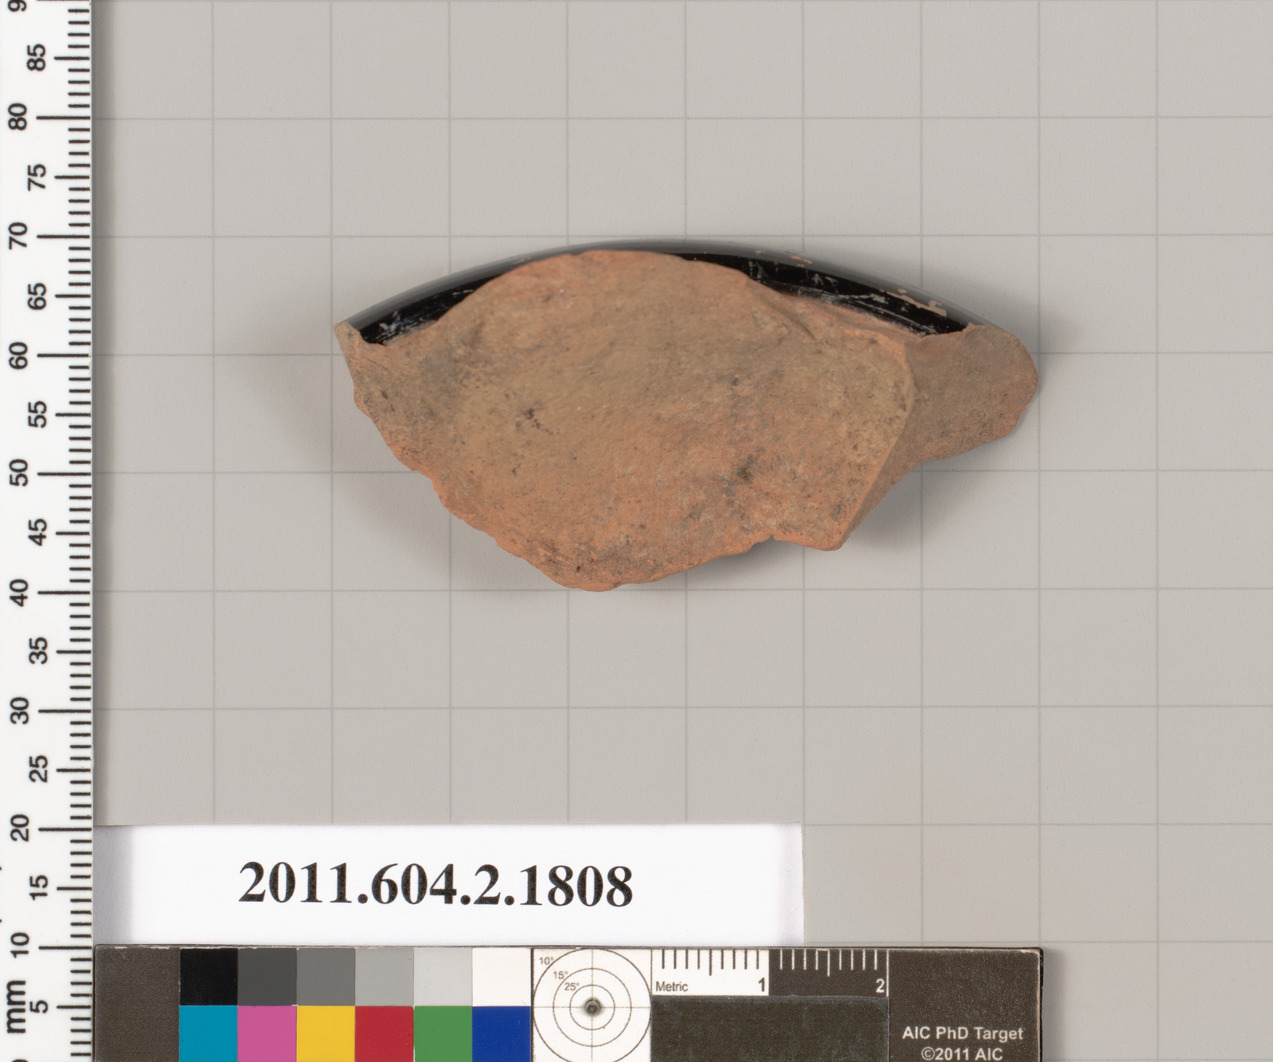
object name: skyphos fragment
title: Terracotta fragment of a skyphos (deep drinking cup)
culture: greek, attic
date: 500-401 BCE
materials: terracotta